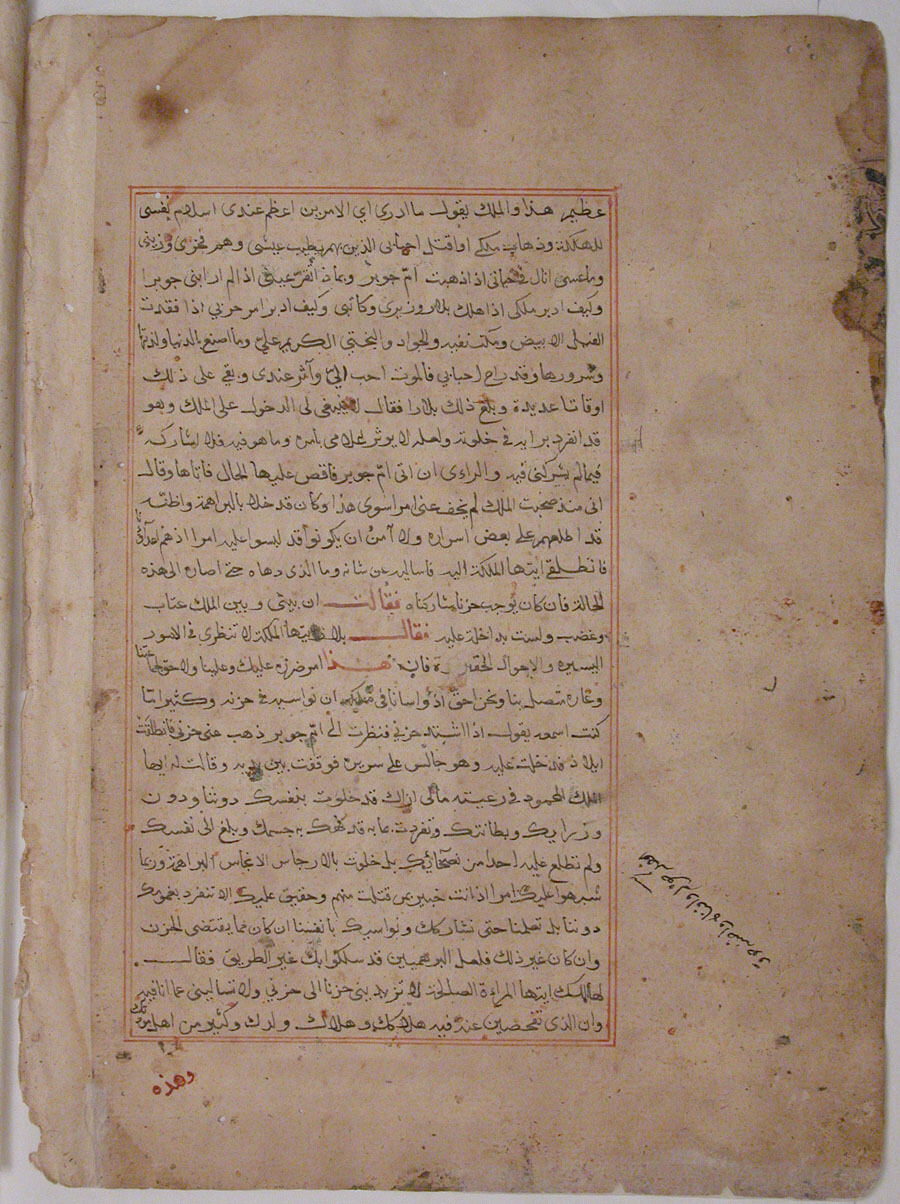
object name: folio from an illustrated manuscript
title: Page of Calligraphy from a Kalila wa Dimna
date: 1526-1550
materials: ink, paper, watercolor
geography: india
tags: arabic,calligraphy